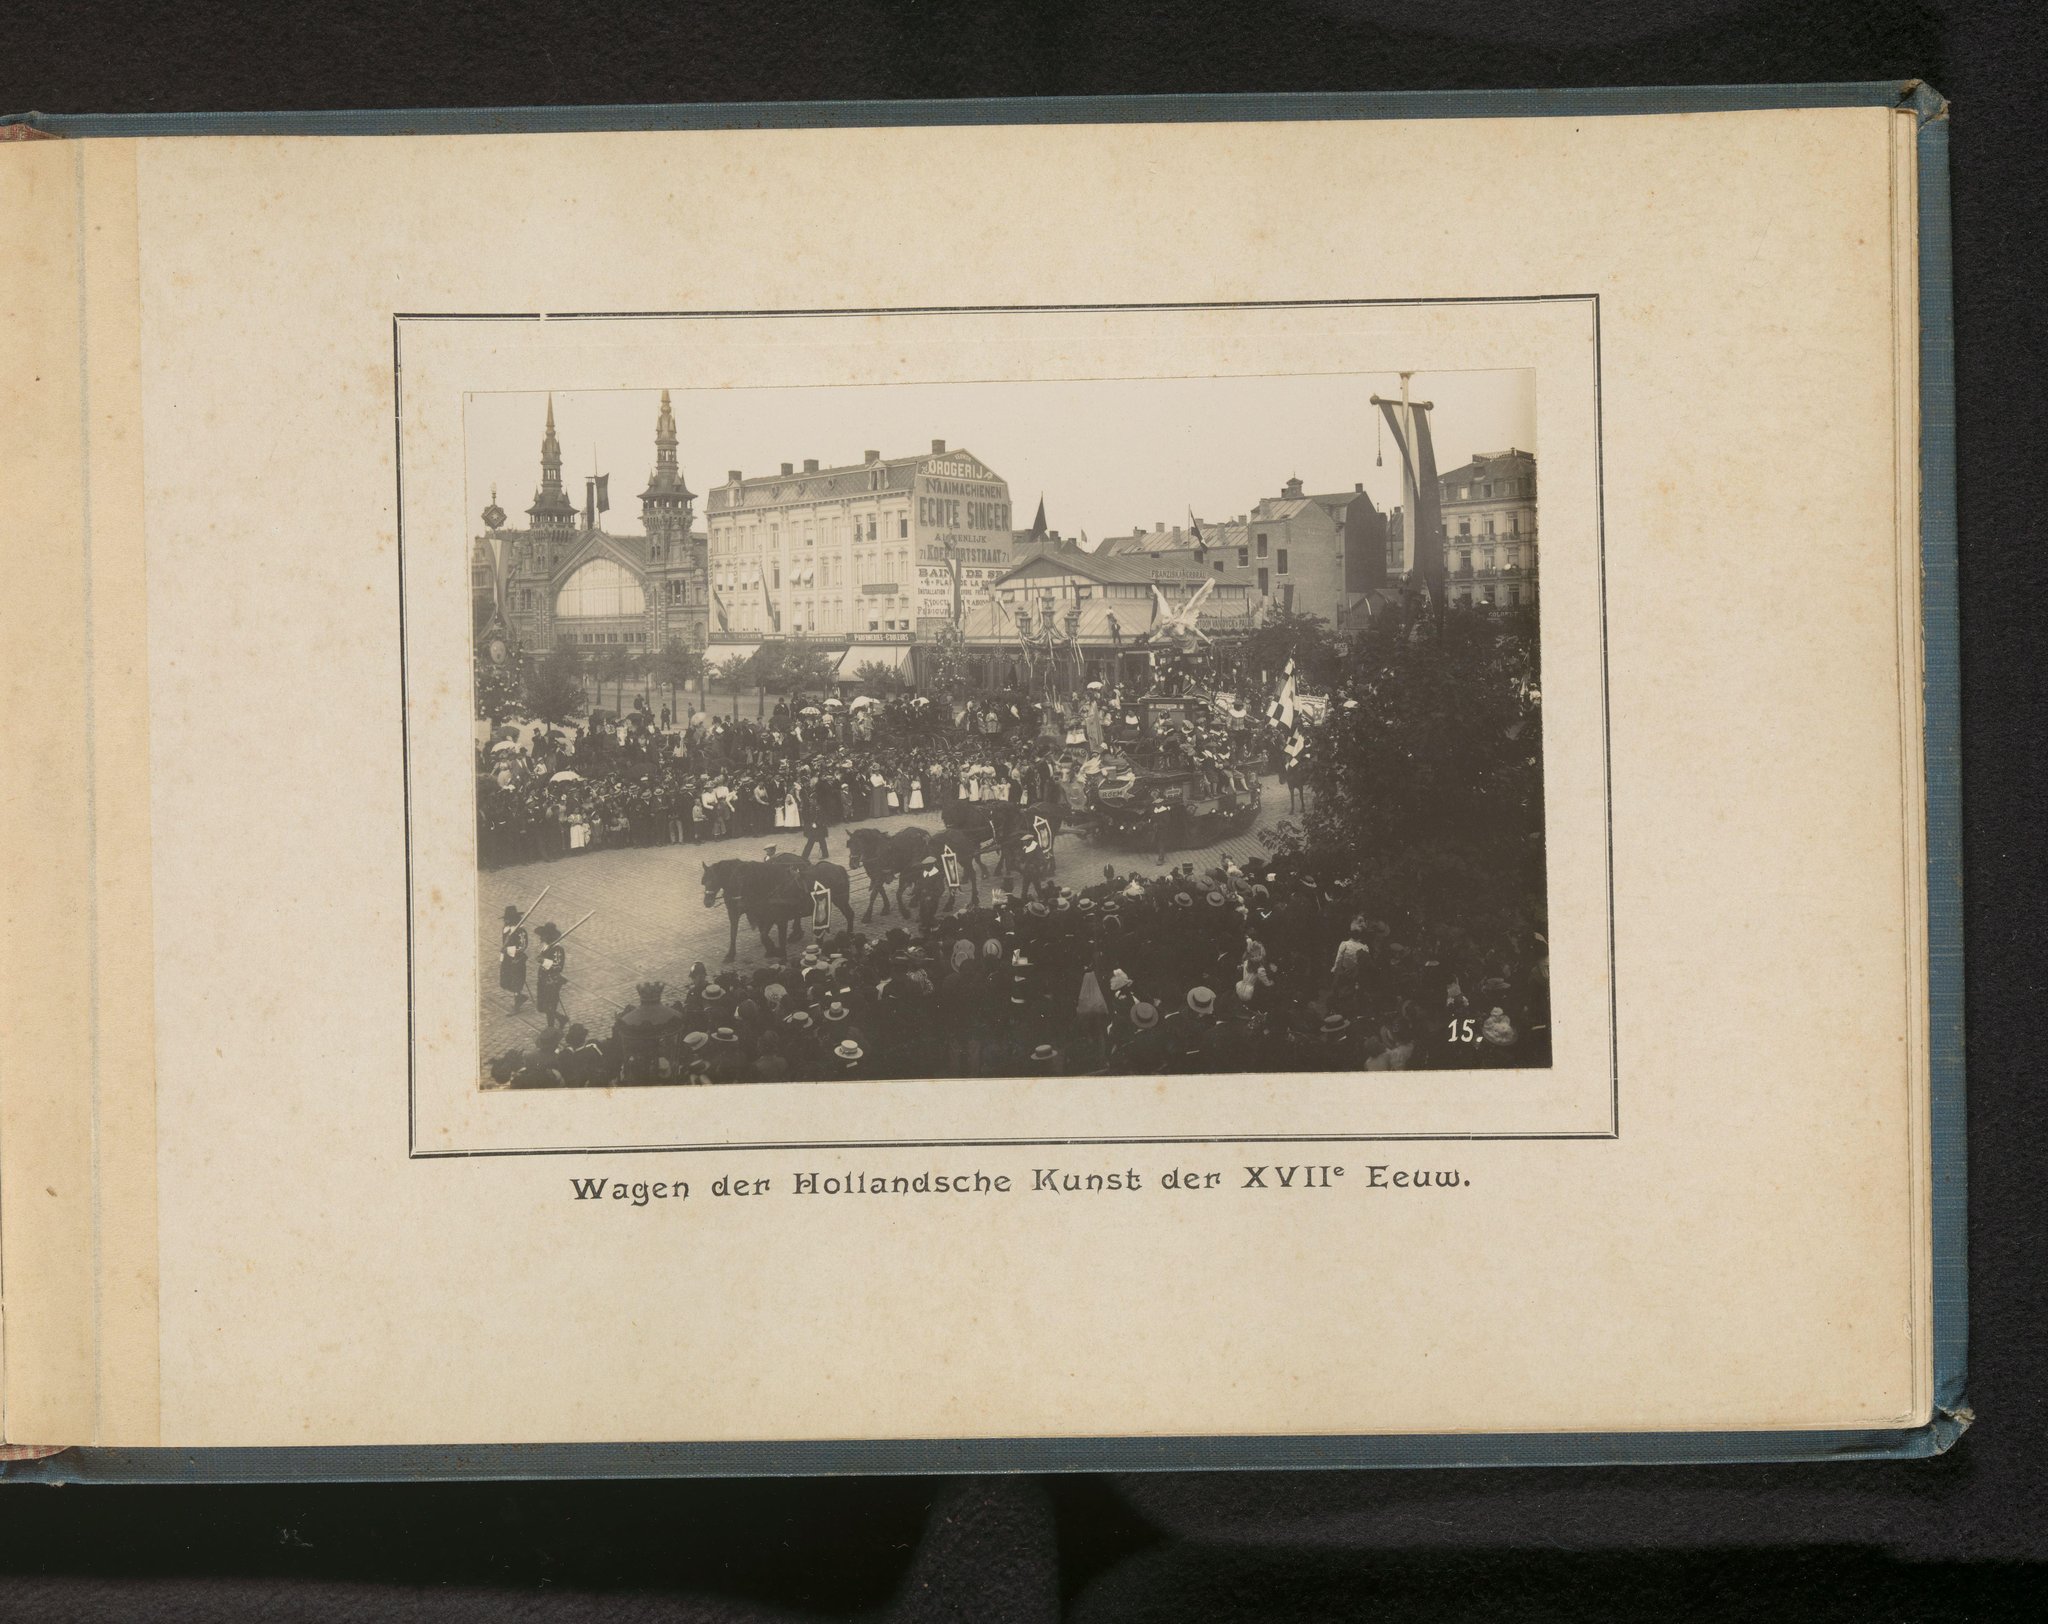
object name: page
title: Wagen der Hollandsche kunst der XVIIe eeuw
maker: Anonymous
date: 1899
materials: photographic support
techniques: printing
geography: antwerp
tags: animal traction, animal-drawn vehicle (carriage etc.), festivities (+ decorated float, wagon ~ festive activities), civic architecture; edifices; dwellings, antwerp